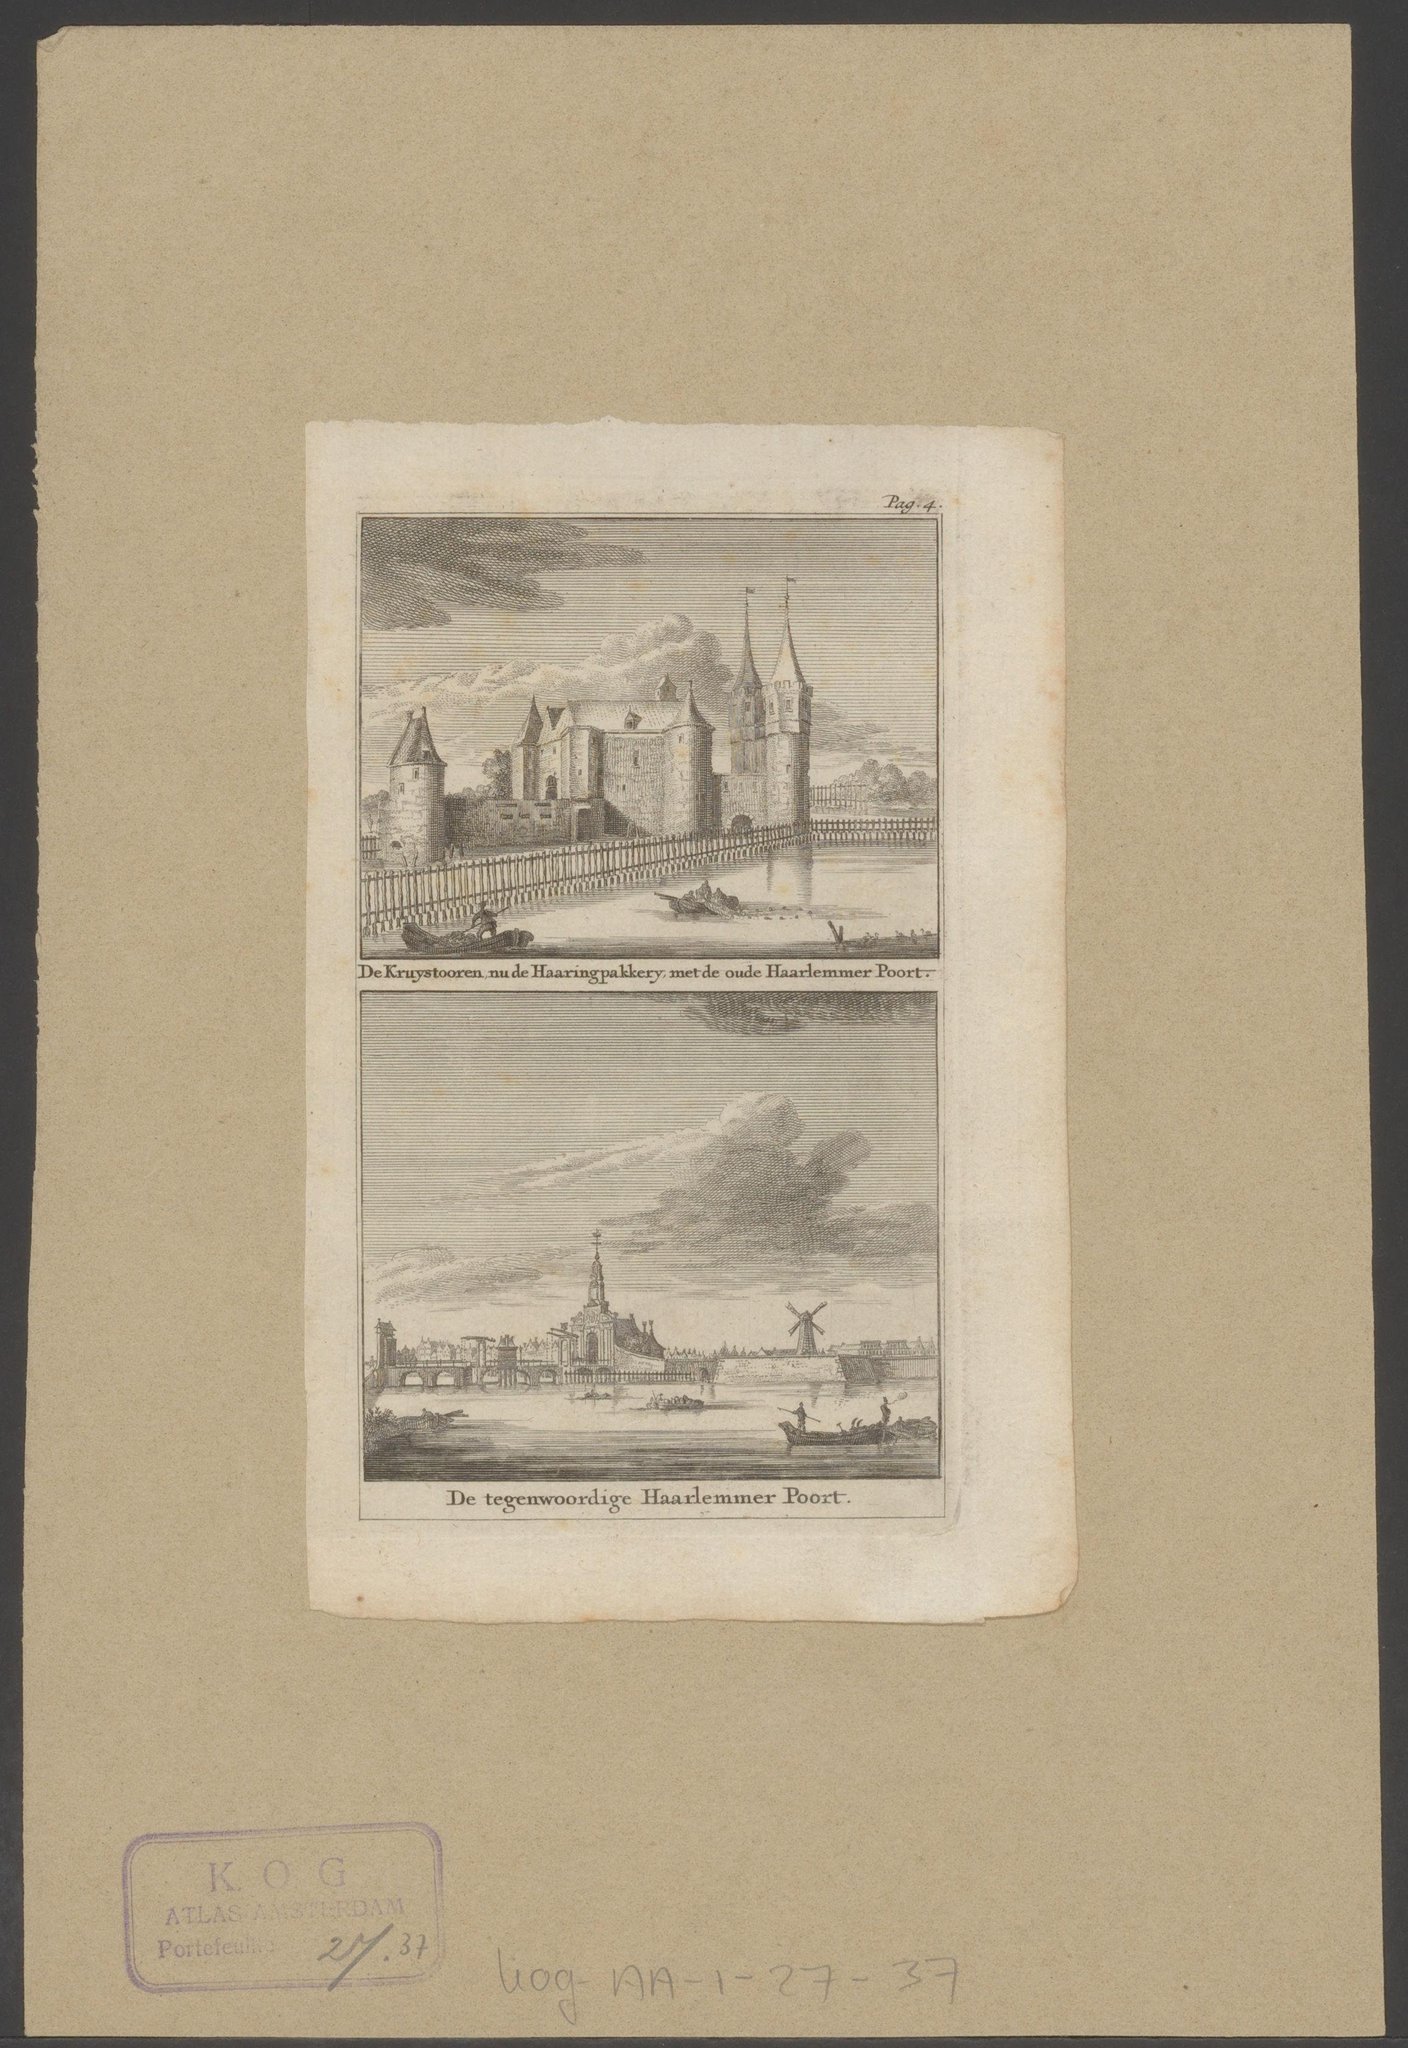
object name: print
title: Gezicht op de Derde en Vierde Haarlemmerpoort te Amsterdam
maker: jan goeree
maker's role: draughtsman, print maker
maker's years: 1670-1731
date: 1723-1738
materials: paper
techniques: engraving, etching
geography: amsterdam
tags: rowing-boat, canoe, etc., city-gate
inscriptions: collector's mark: Lugt 1641b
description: Prent mogelijk uit: Willink, Daniël. Daniël Willinks Amsterdamsche Buitensingel Nevens de omleggende dorpen, opgeheldert door aanteekeningen (…). Amsterdam: Andries van Damme, 1723. Of uit: Willink, Daniël. Daniël Willinks Amsterdamsche Buitensingel, Nevens de omleggende dorpen, opgeheldert door aanteekeningen (…). Amsterdam: Arend van Huyssteen, 1738.